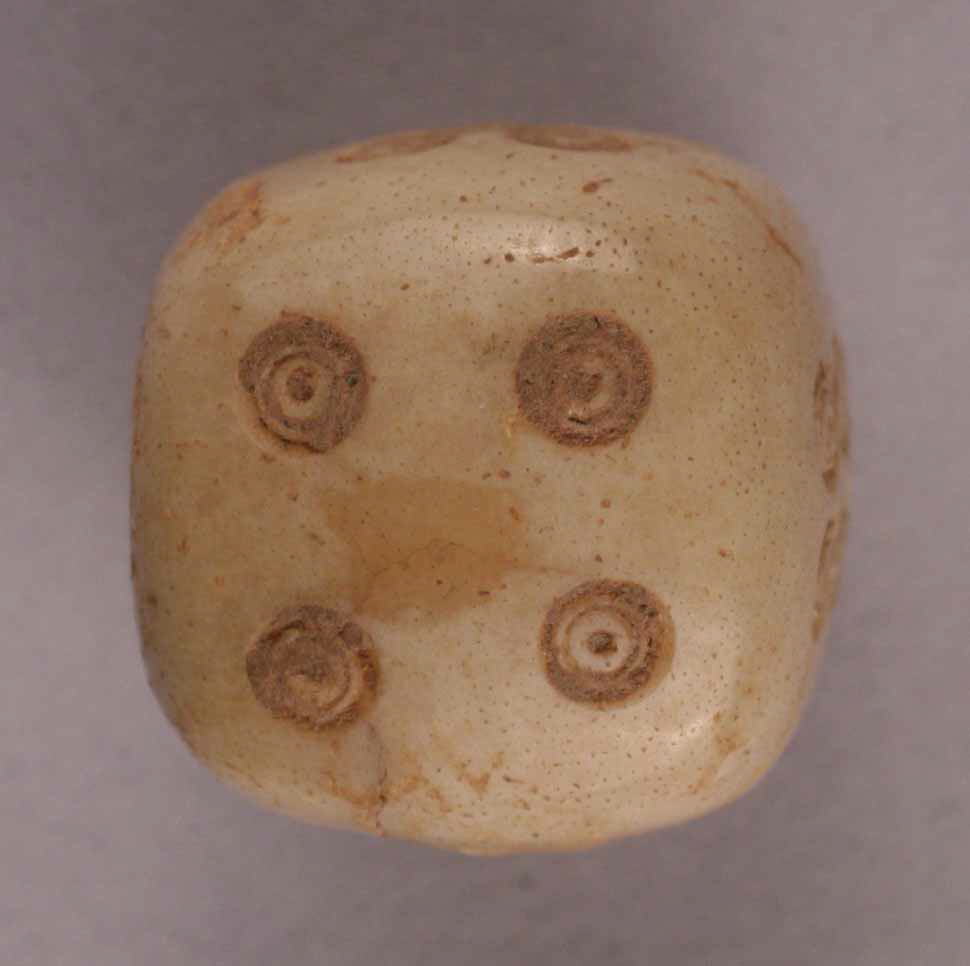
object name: dice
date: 801-1000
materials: bone, paint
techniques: incising, inlay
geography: iran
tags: dice